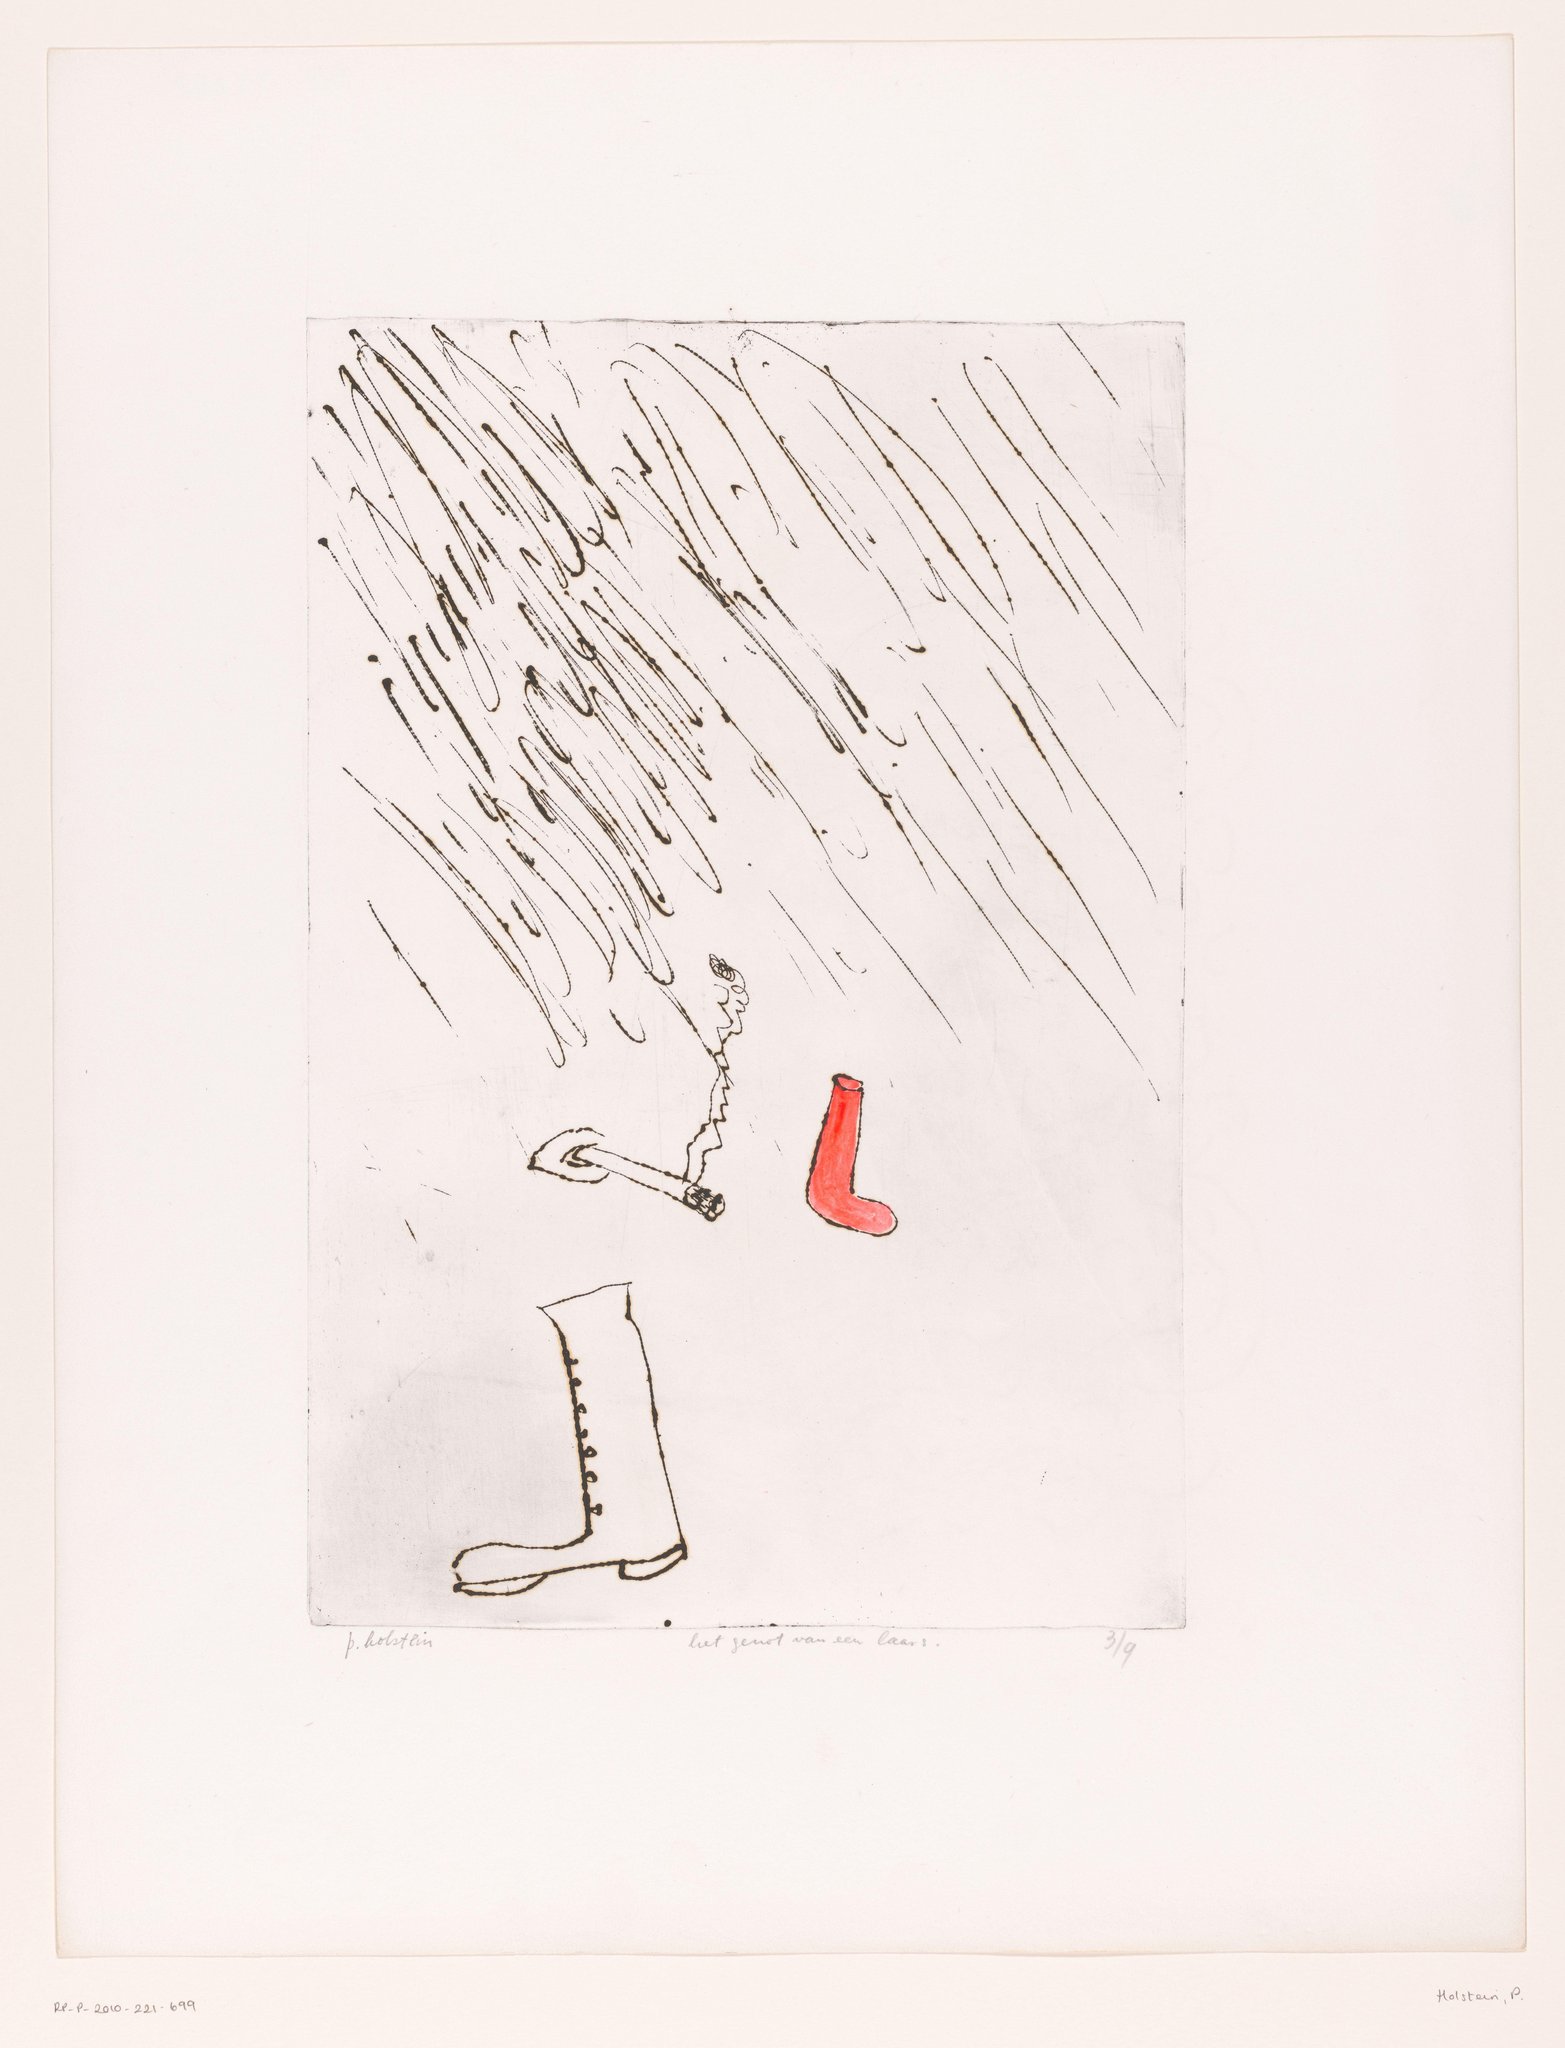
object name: print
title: Het genot van een laars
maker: pieter holstein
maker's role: draughtsman, painter, print maker, sculptor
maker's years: 1934-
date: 1965-1968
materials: paper, watercolor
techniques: brush, etching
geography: amsterdam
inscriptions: edition: ‘3/9’, signature: ‘p. holstein’, title: ‘het genot van een laars.’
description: Veterlaars, brandende sigaret en neonroze sok.